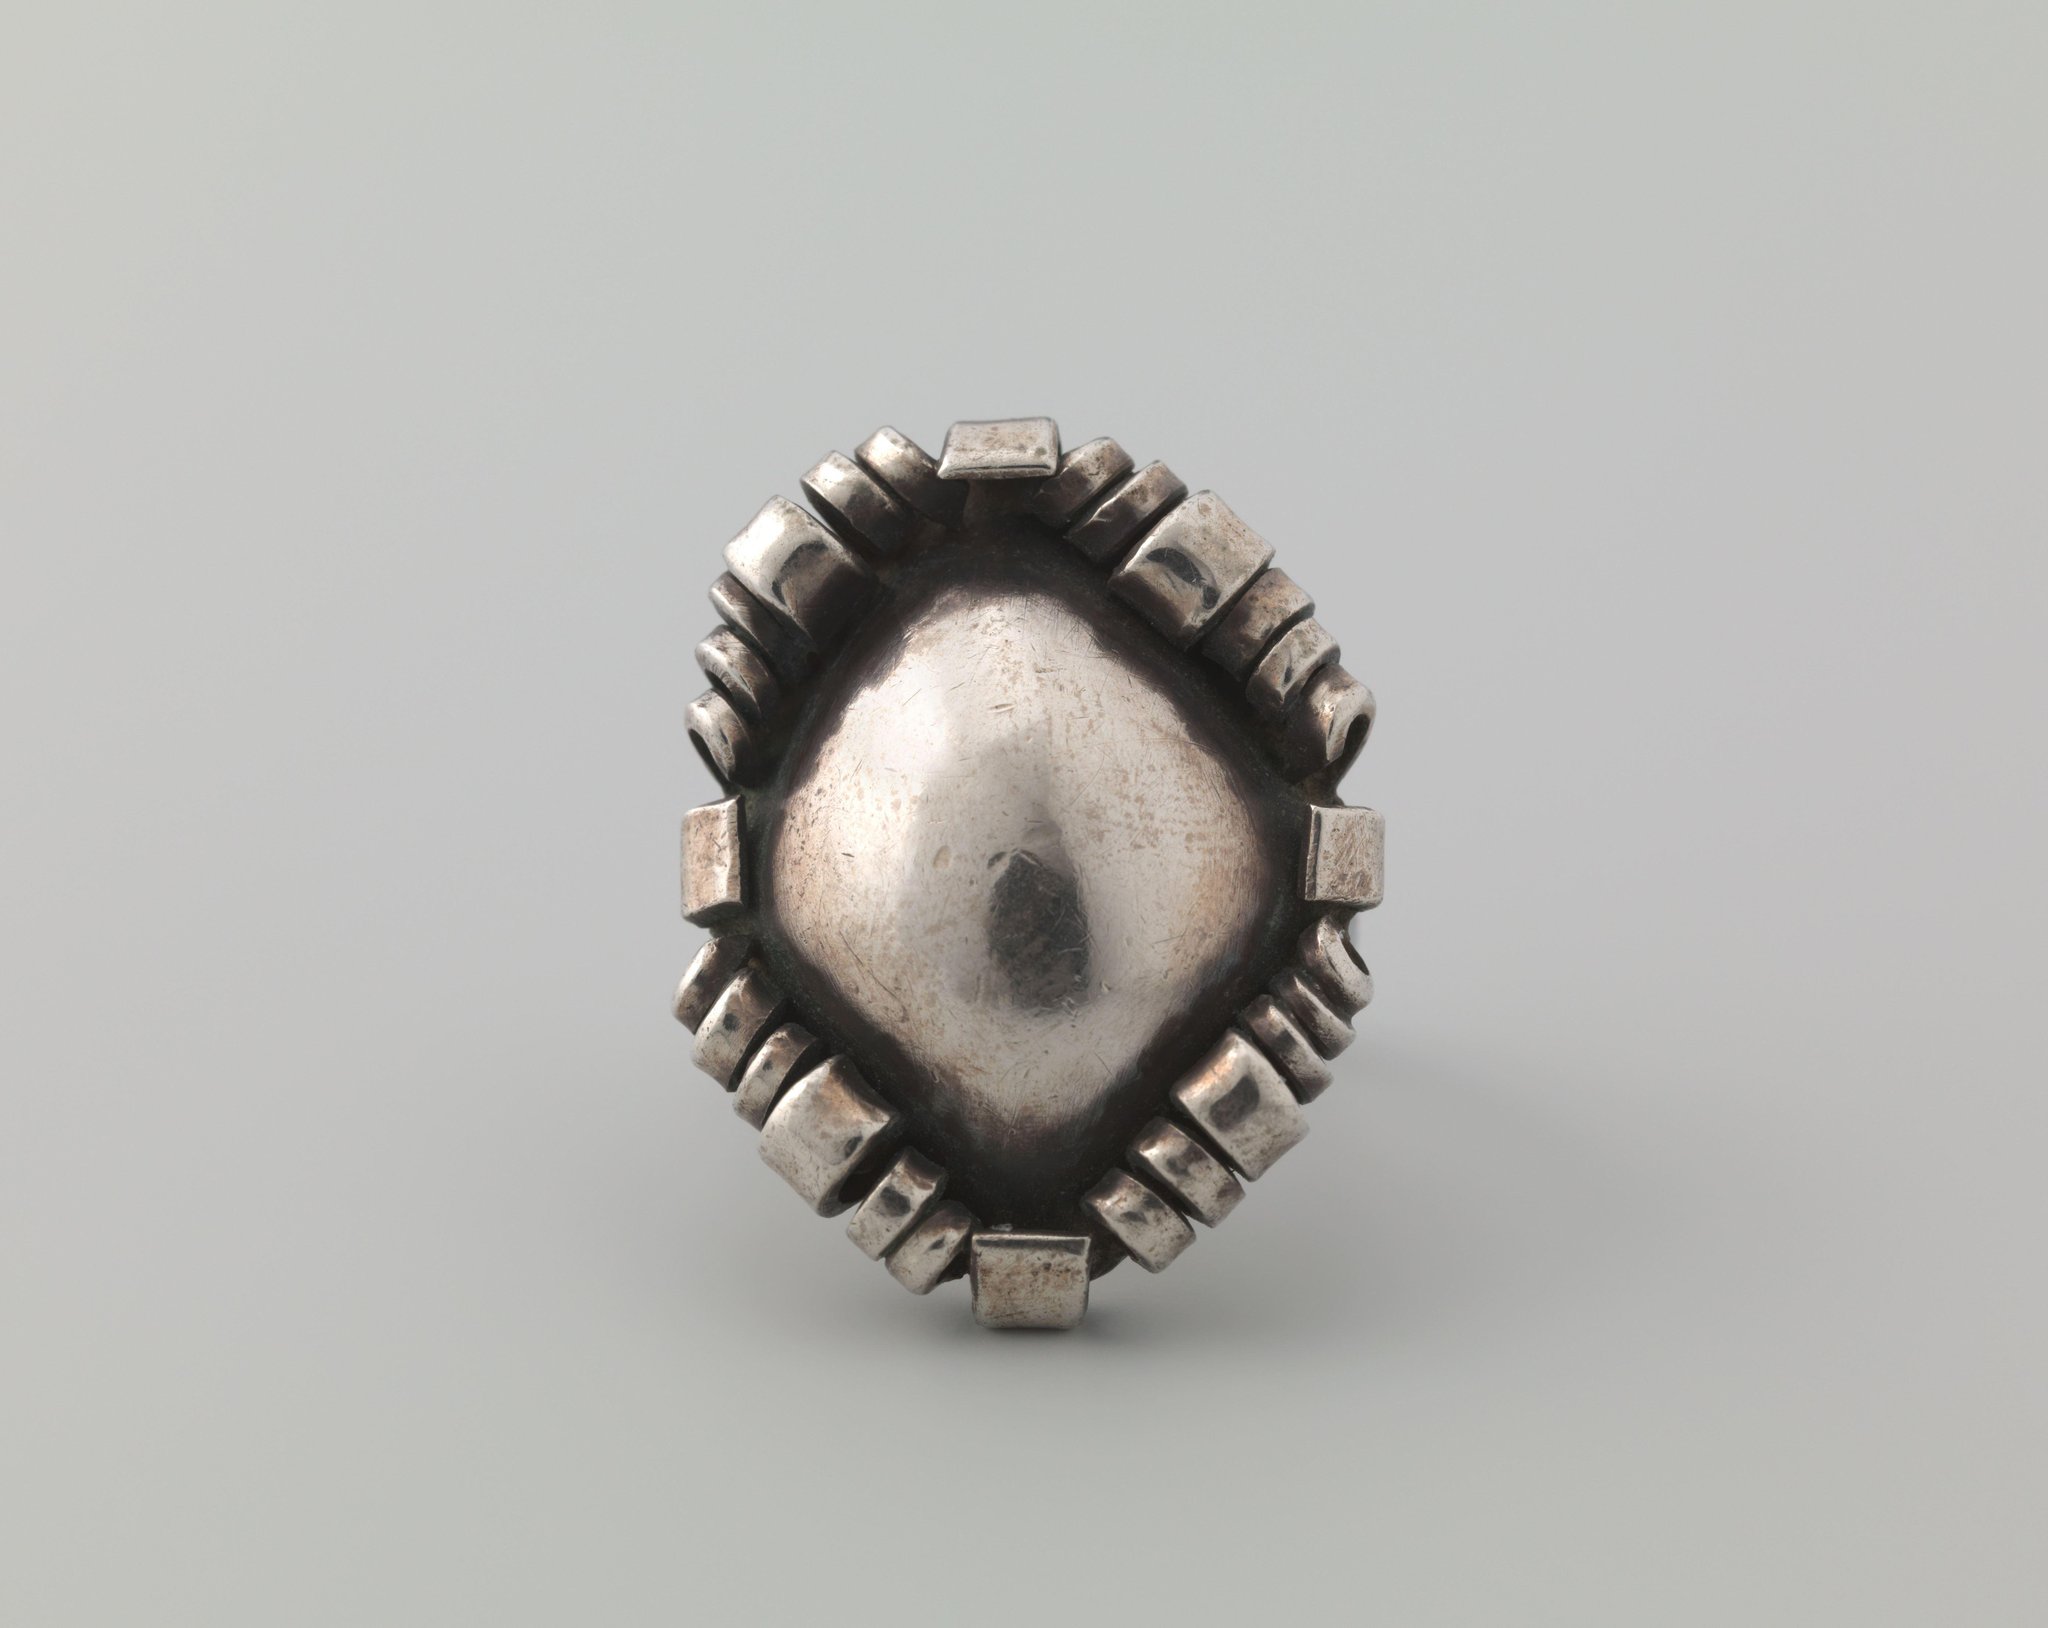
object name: ring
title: Tienerring van zilver met gladde convexe ruitvormige knop in een geometrische rand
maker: Anonymous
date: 1960-1970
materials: silver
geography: netherlands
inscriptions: maker's mark, alloy mark: ‘I’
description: Tienerring van zilver met gladde convexe ruitvormige knop in een geometrische rand.